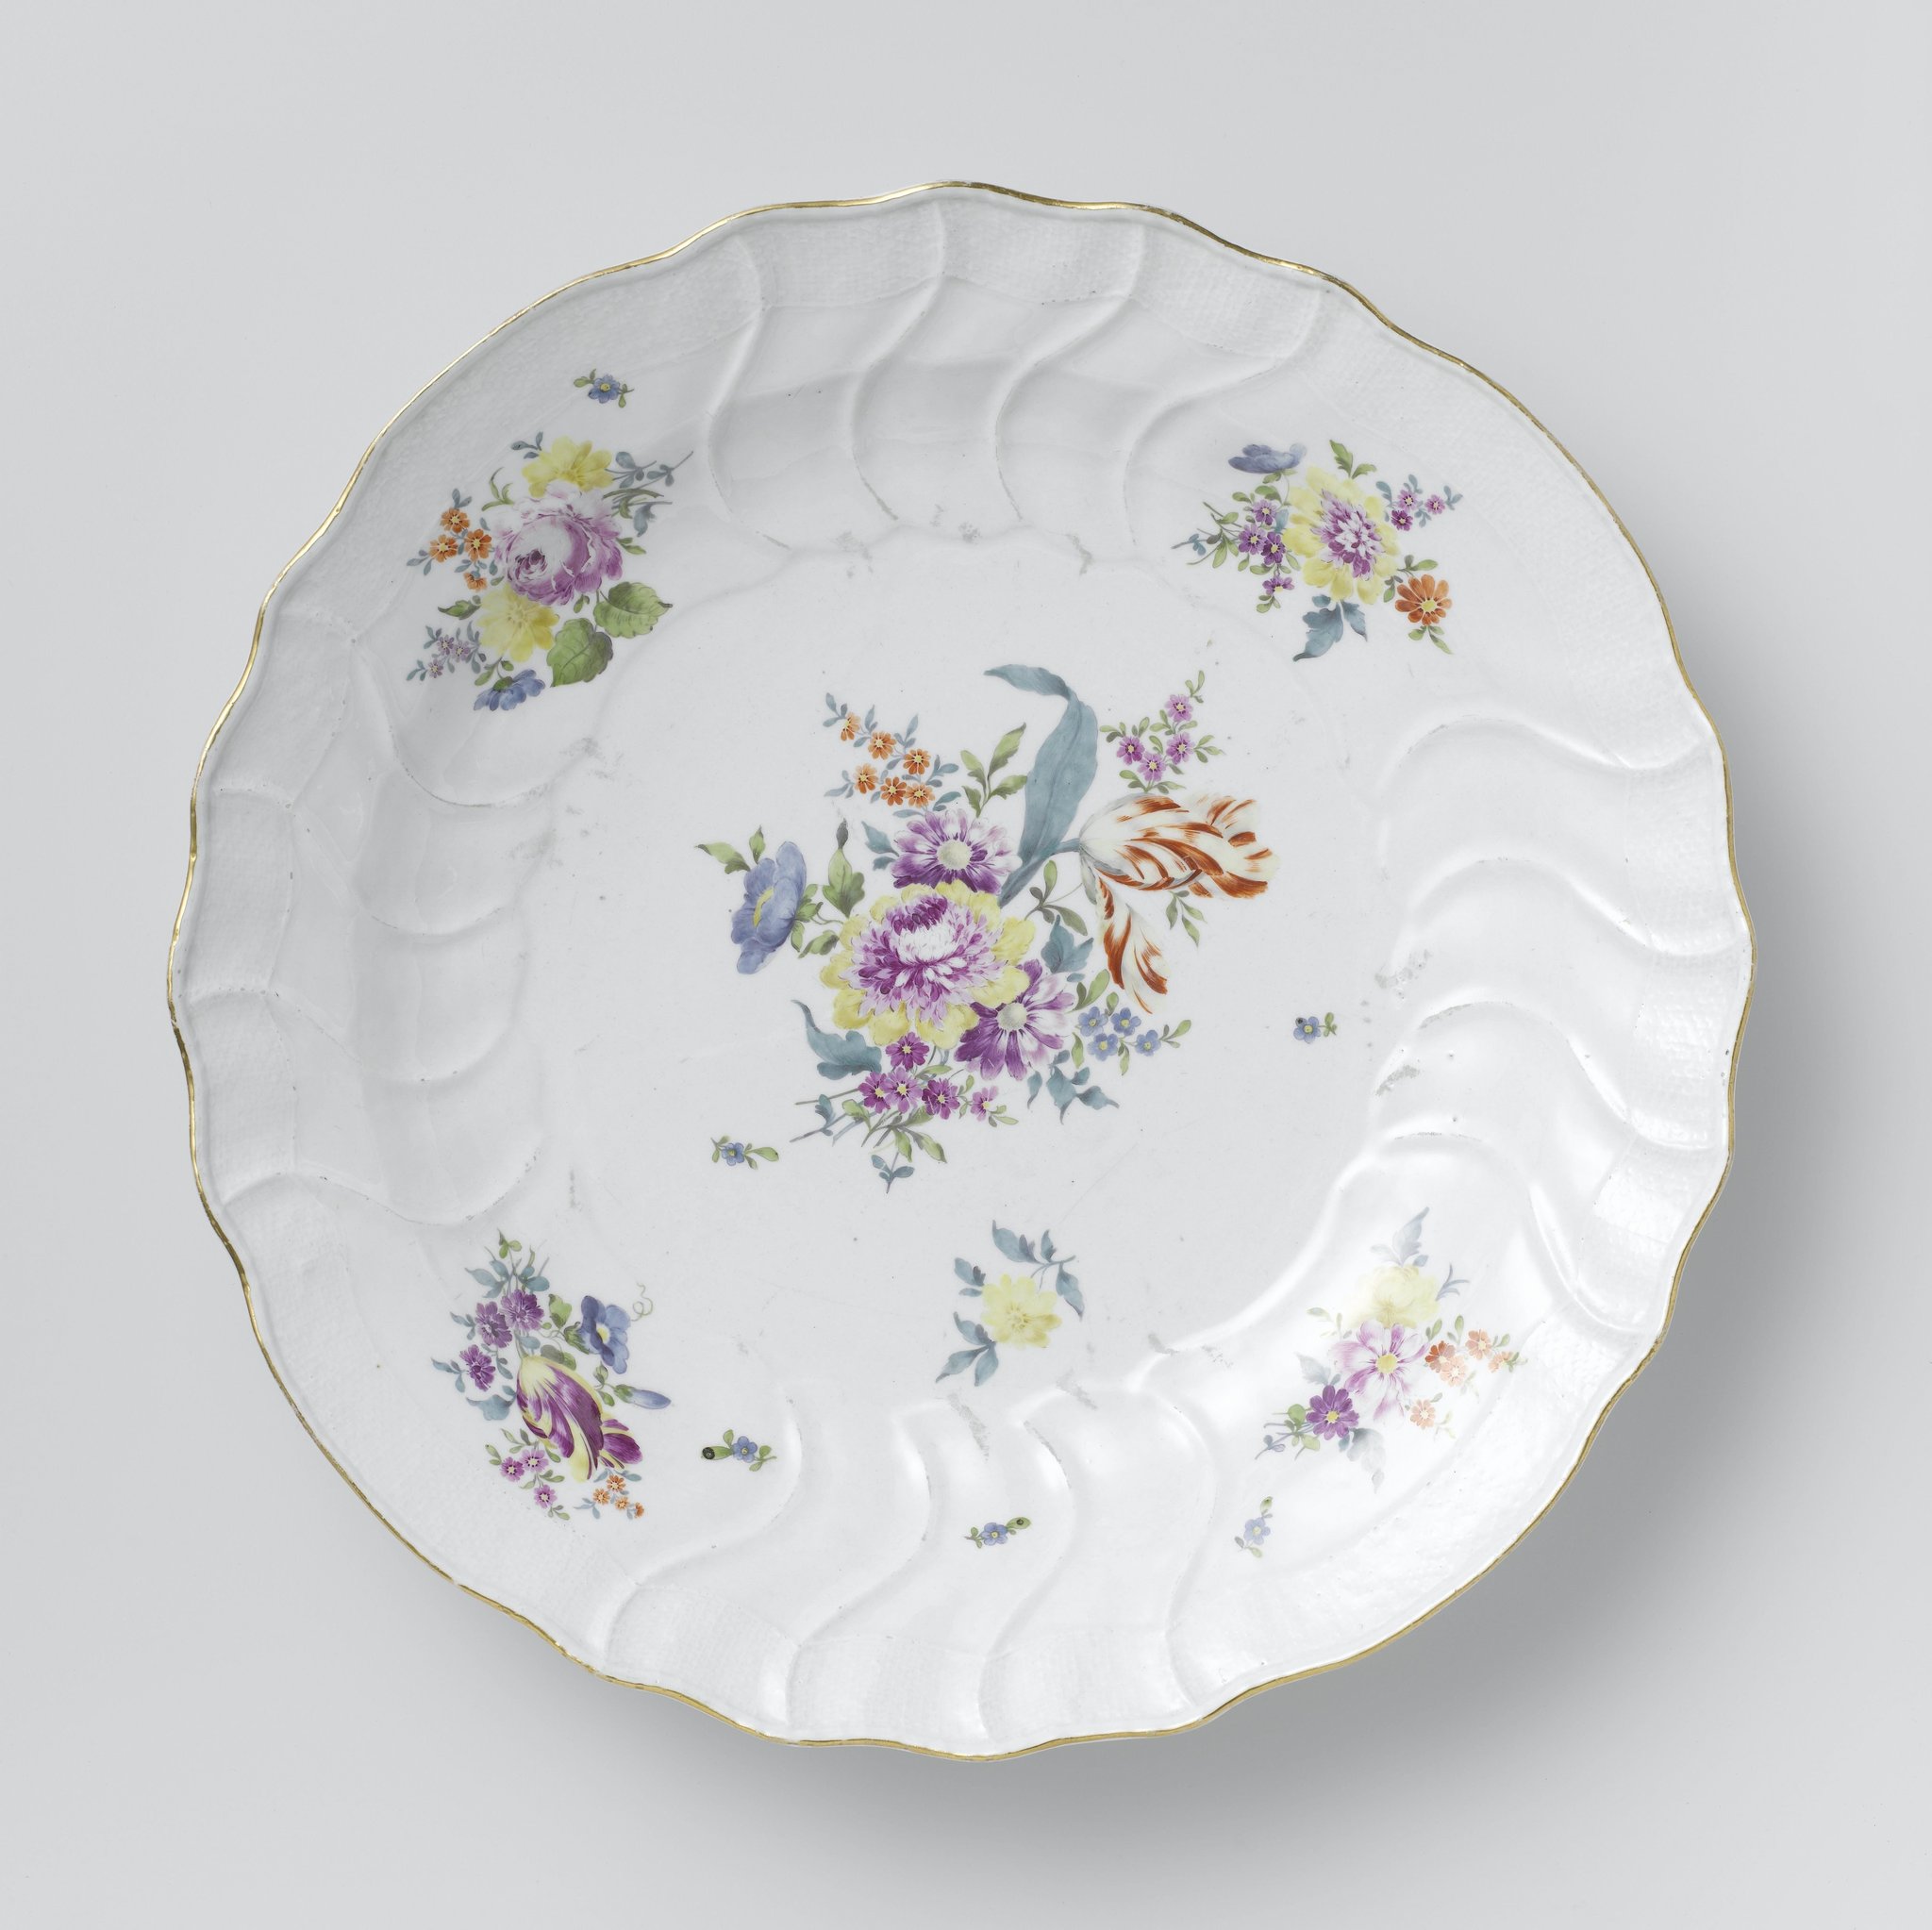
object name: platter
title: Schotel, veelkleurig beschilderd met Deutsche Blumen, insekten en vruchten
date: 1750-1760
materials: porcelain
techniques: painted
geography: meissen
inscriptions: factory mark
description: Ronde schotel van beschilderd porselein. De schotel is beschilderd met Deutsche Blumen, insekten en vruchten. De rand is in reliëf versierd met het Neuozier-patroon. De schotel is gemerkt en hoort bij een servies (BK-17474-1 t/m BK-17474-253).